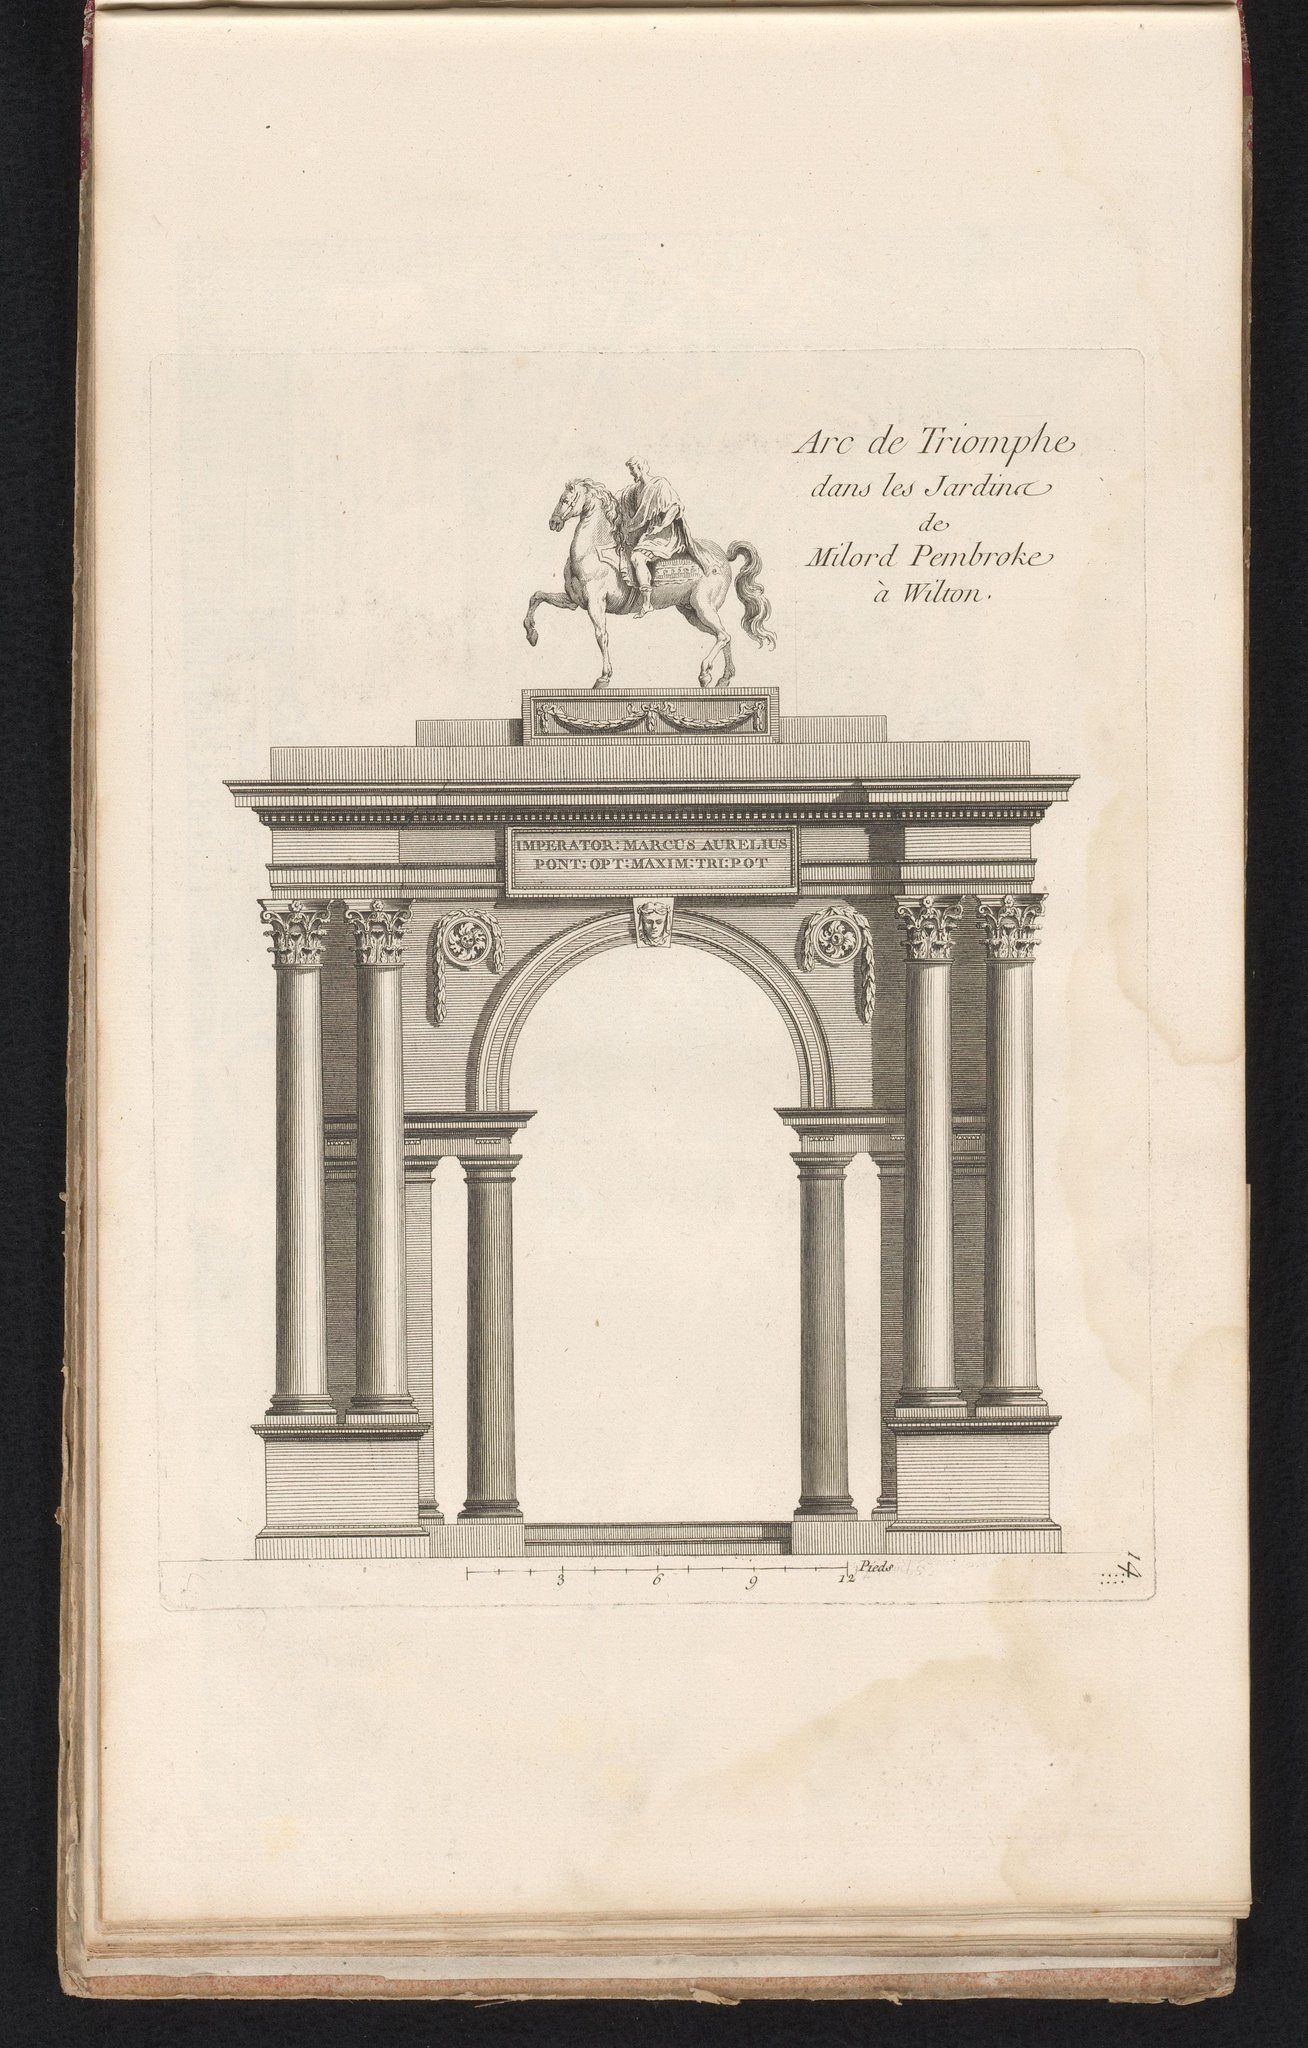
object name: album leaf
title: Arc de triomphe dans les jardins de milord Pembroke à Wilton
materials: paper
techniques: engraving, etching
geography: paris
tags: triumphal arch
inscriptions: collector's mark: Lugt 2228, collector's mark: Lugt 2760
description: De serie 'Jardins anglo-chinois à la mode' verscheen in totaal in 21 zogeheten 'cahiers' (afleveringen). De huidige prent komt uit het achtste 'cahier'. Het Rijksmuseum Amsterdam bezit drie banden met daarin in totaal zes 'cahiers' van deze reeks. In de documentatie wordt verwezen naar een in de bibliotheek van het Rijksmuseum Amsterdam aanwezige facsimile van het complete werk.